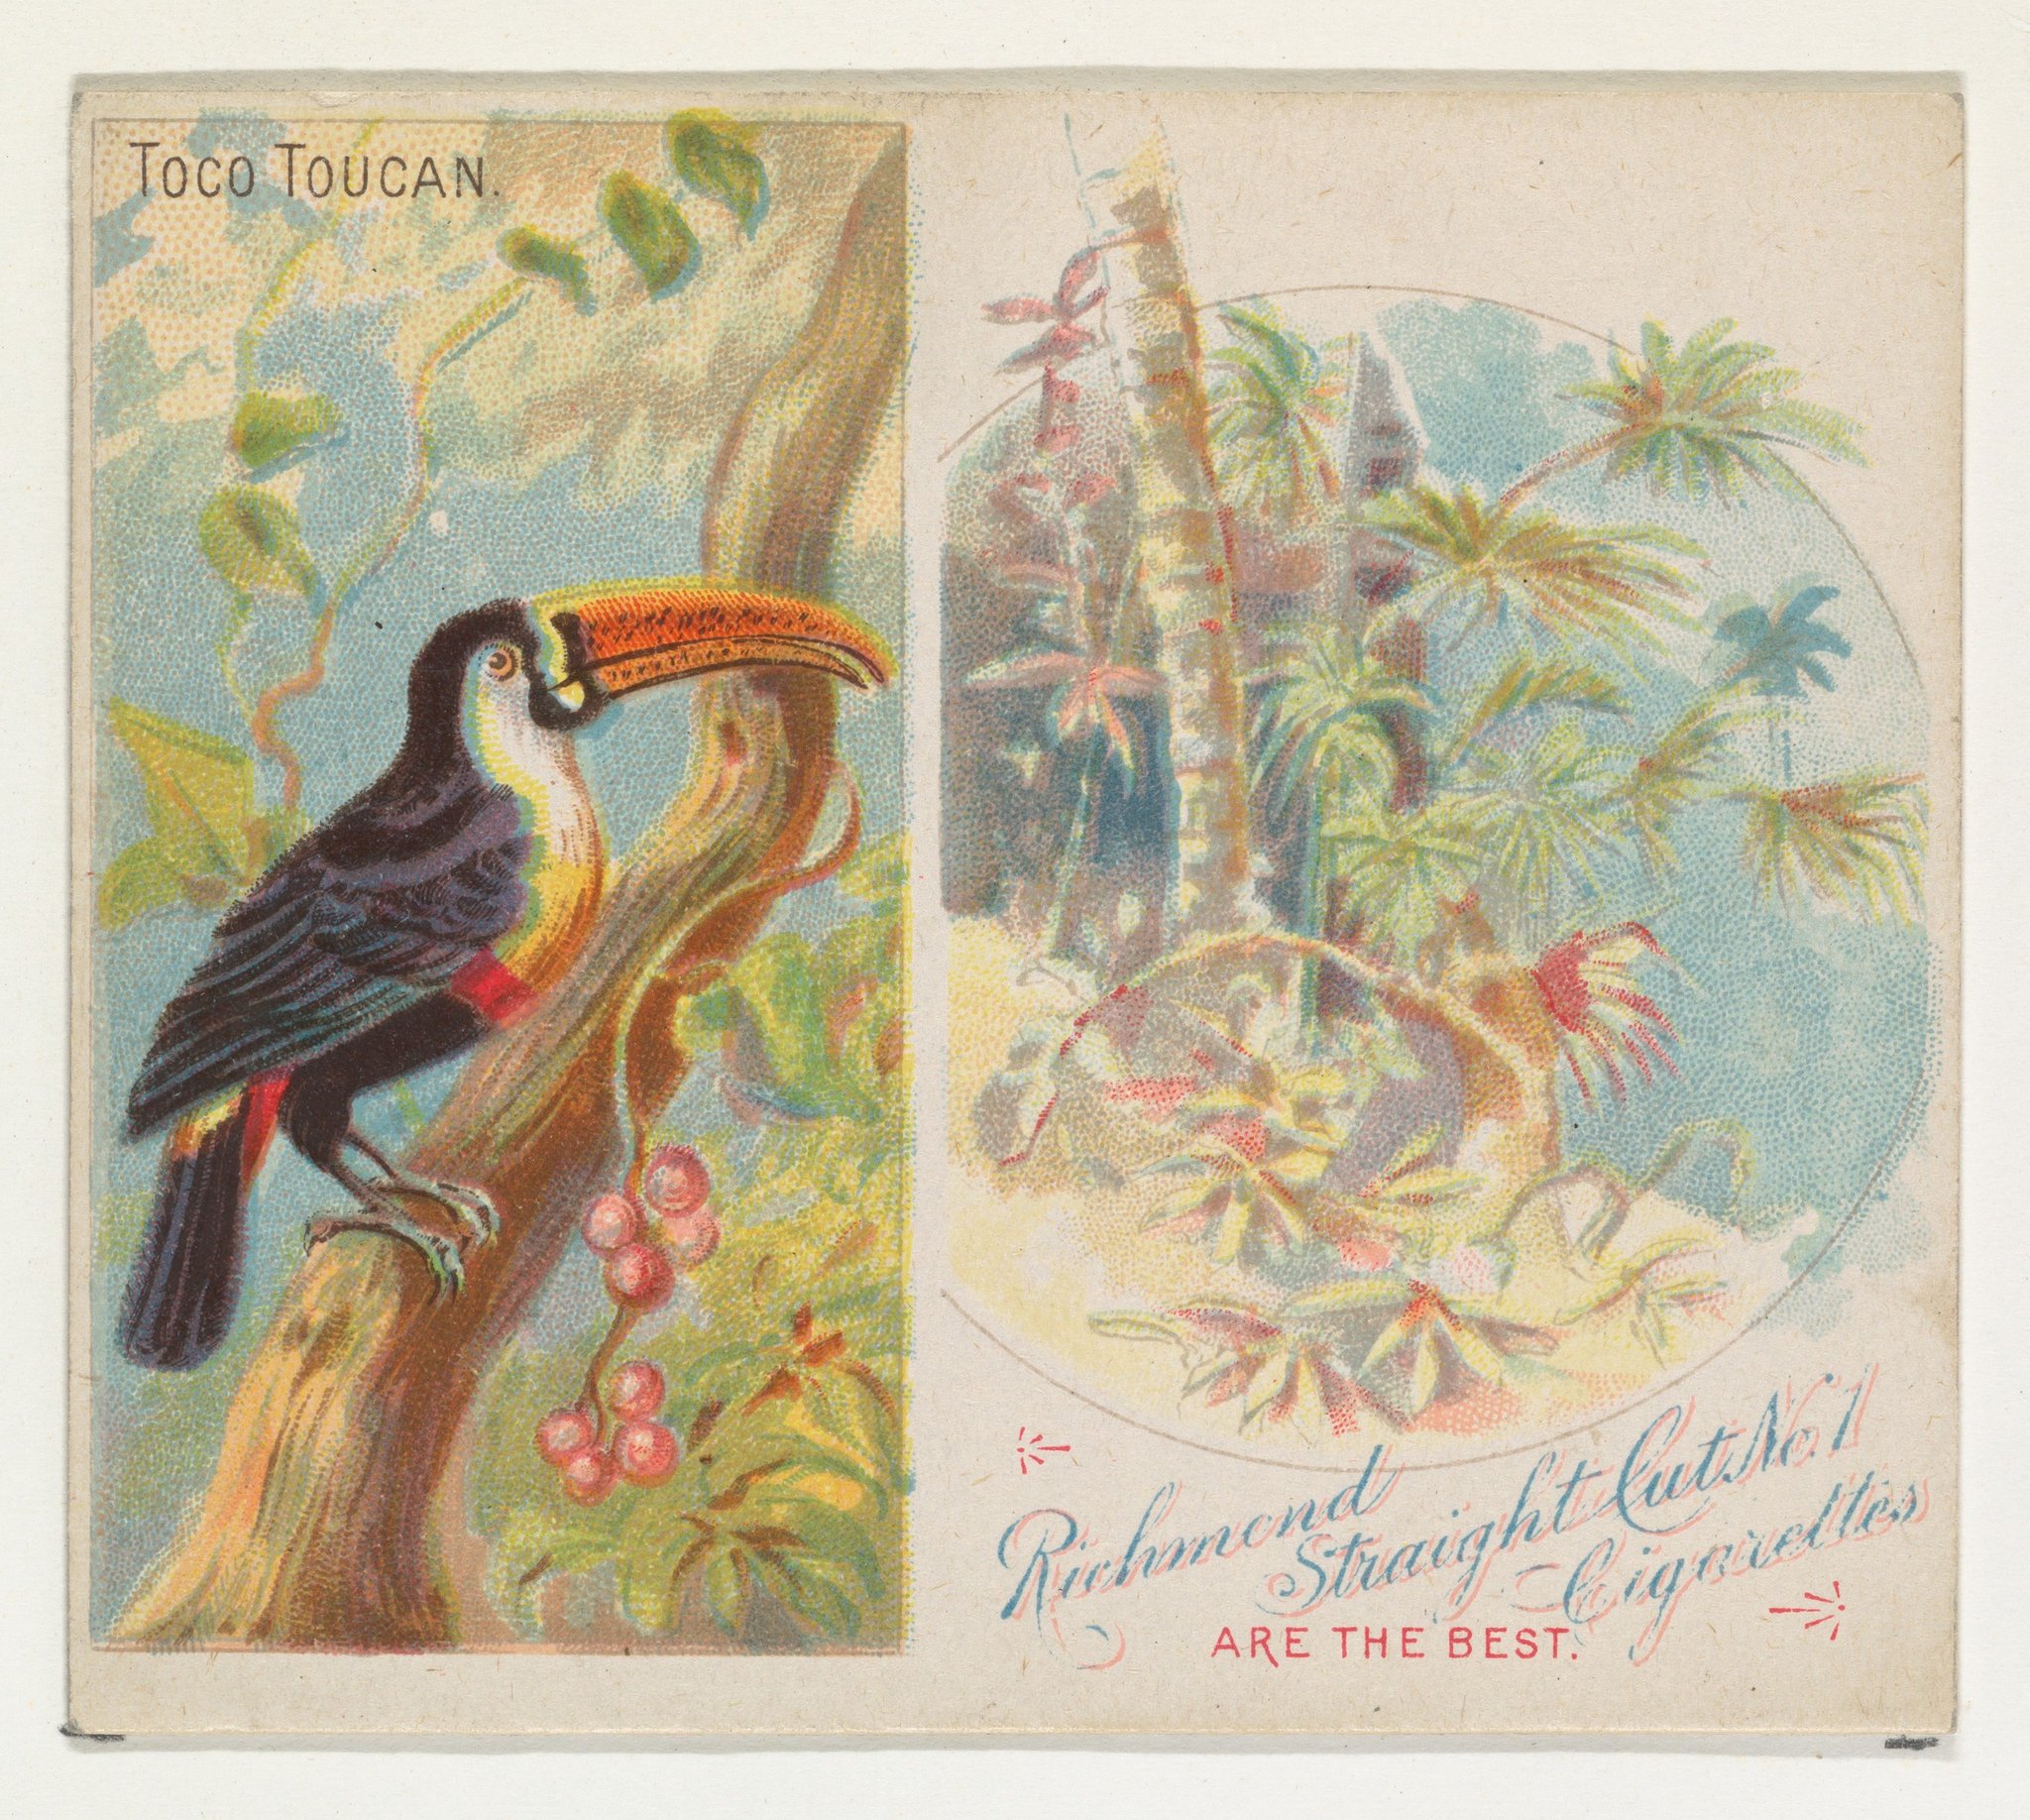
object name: print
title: Toco Toucan, from Birds of the Tropics series (N38) for Allen & Ginter Cigarettes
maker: allen & ginter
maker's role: publisher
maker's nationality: american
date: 1889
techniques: color lithograph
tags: birds